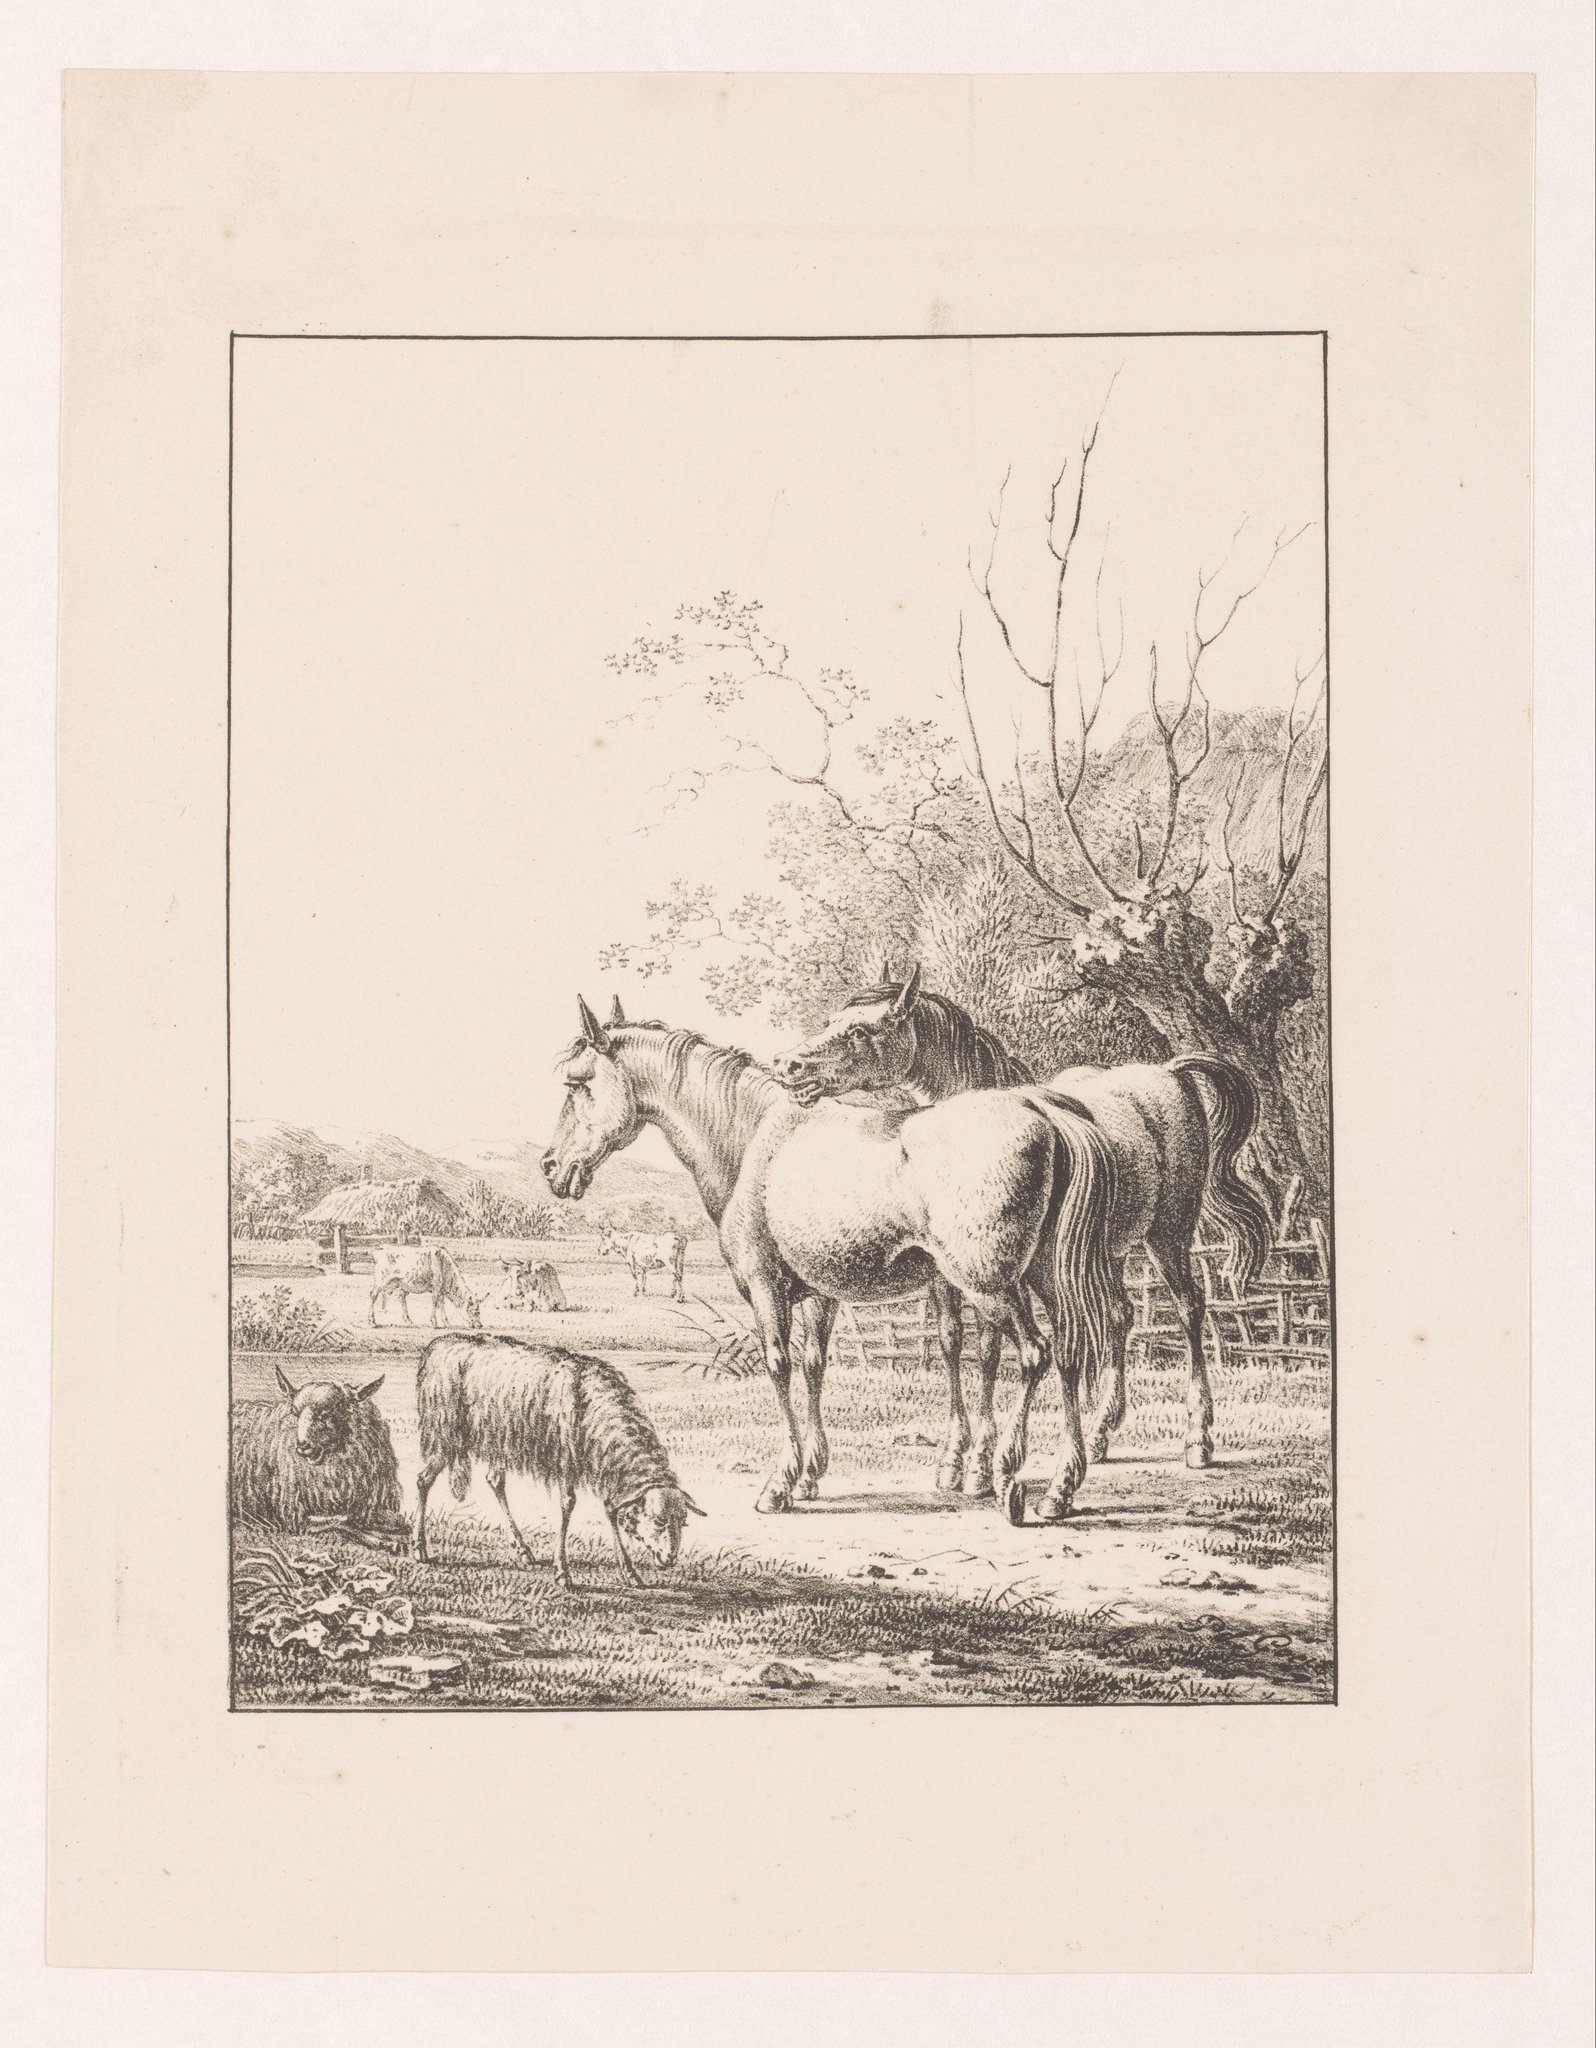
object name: print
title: Twee paarden, twee schapen en koeien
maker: pieter de goeje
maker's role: draughtsman, print maker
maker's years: 1789-1859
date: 1809-1859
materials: paper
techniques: lithograph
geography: netherlands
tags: cow, meadow, pasture, sheep, horse, farm (building)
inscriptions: collector's mark: Lugt 2228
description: Een paard kijkt over de rug van het tweede paard en heeft zijn mond open gesperd. Links twee schapen. In een weiland bij de boerderij drie koeien.